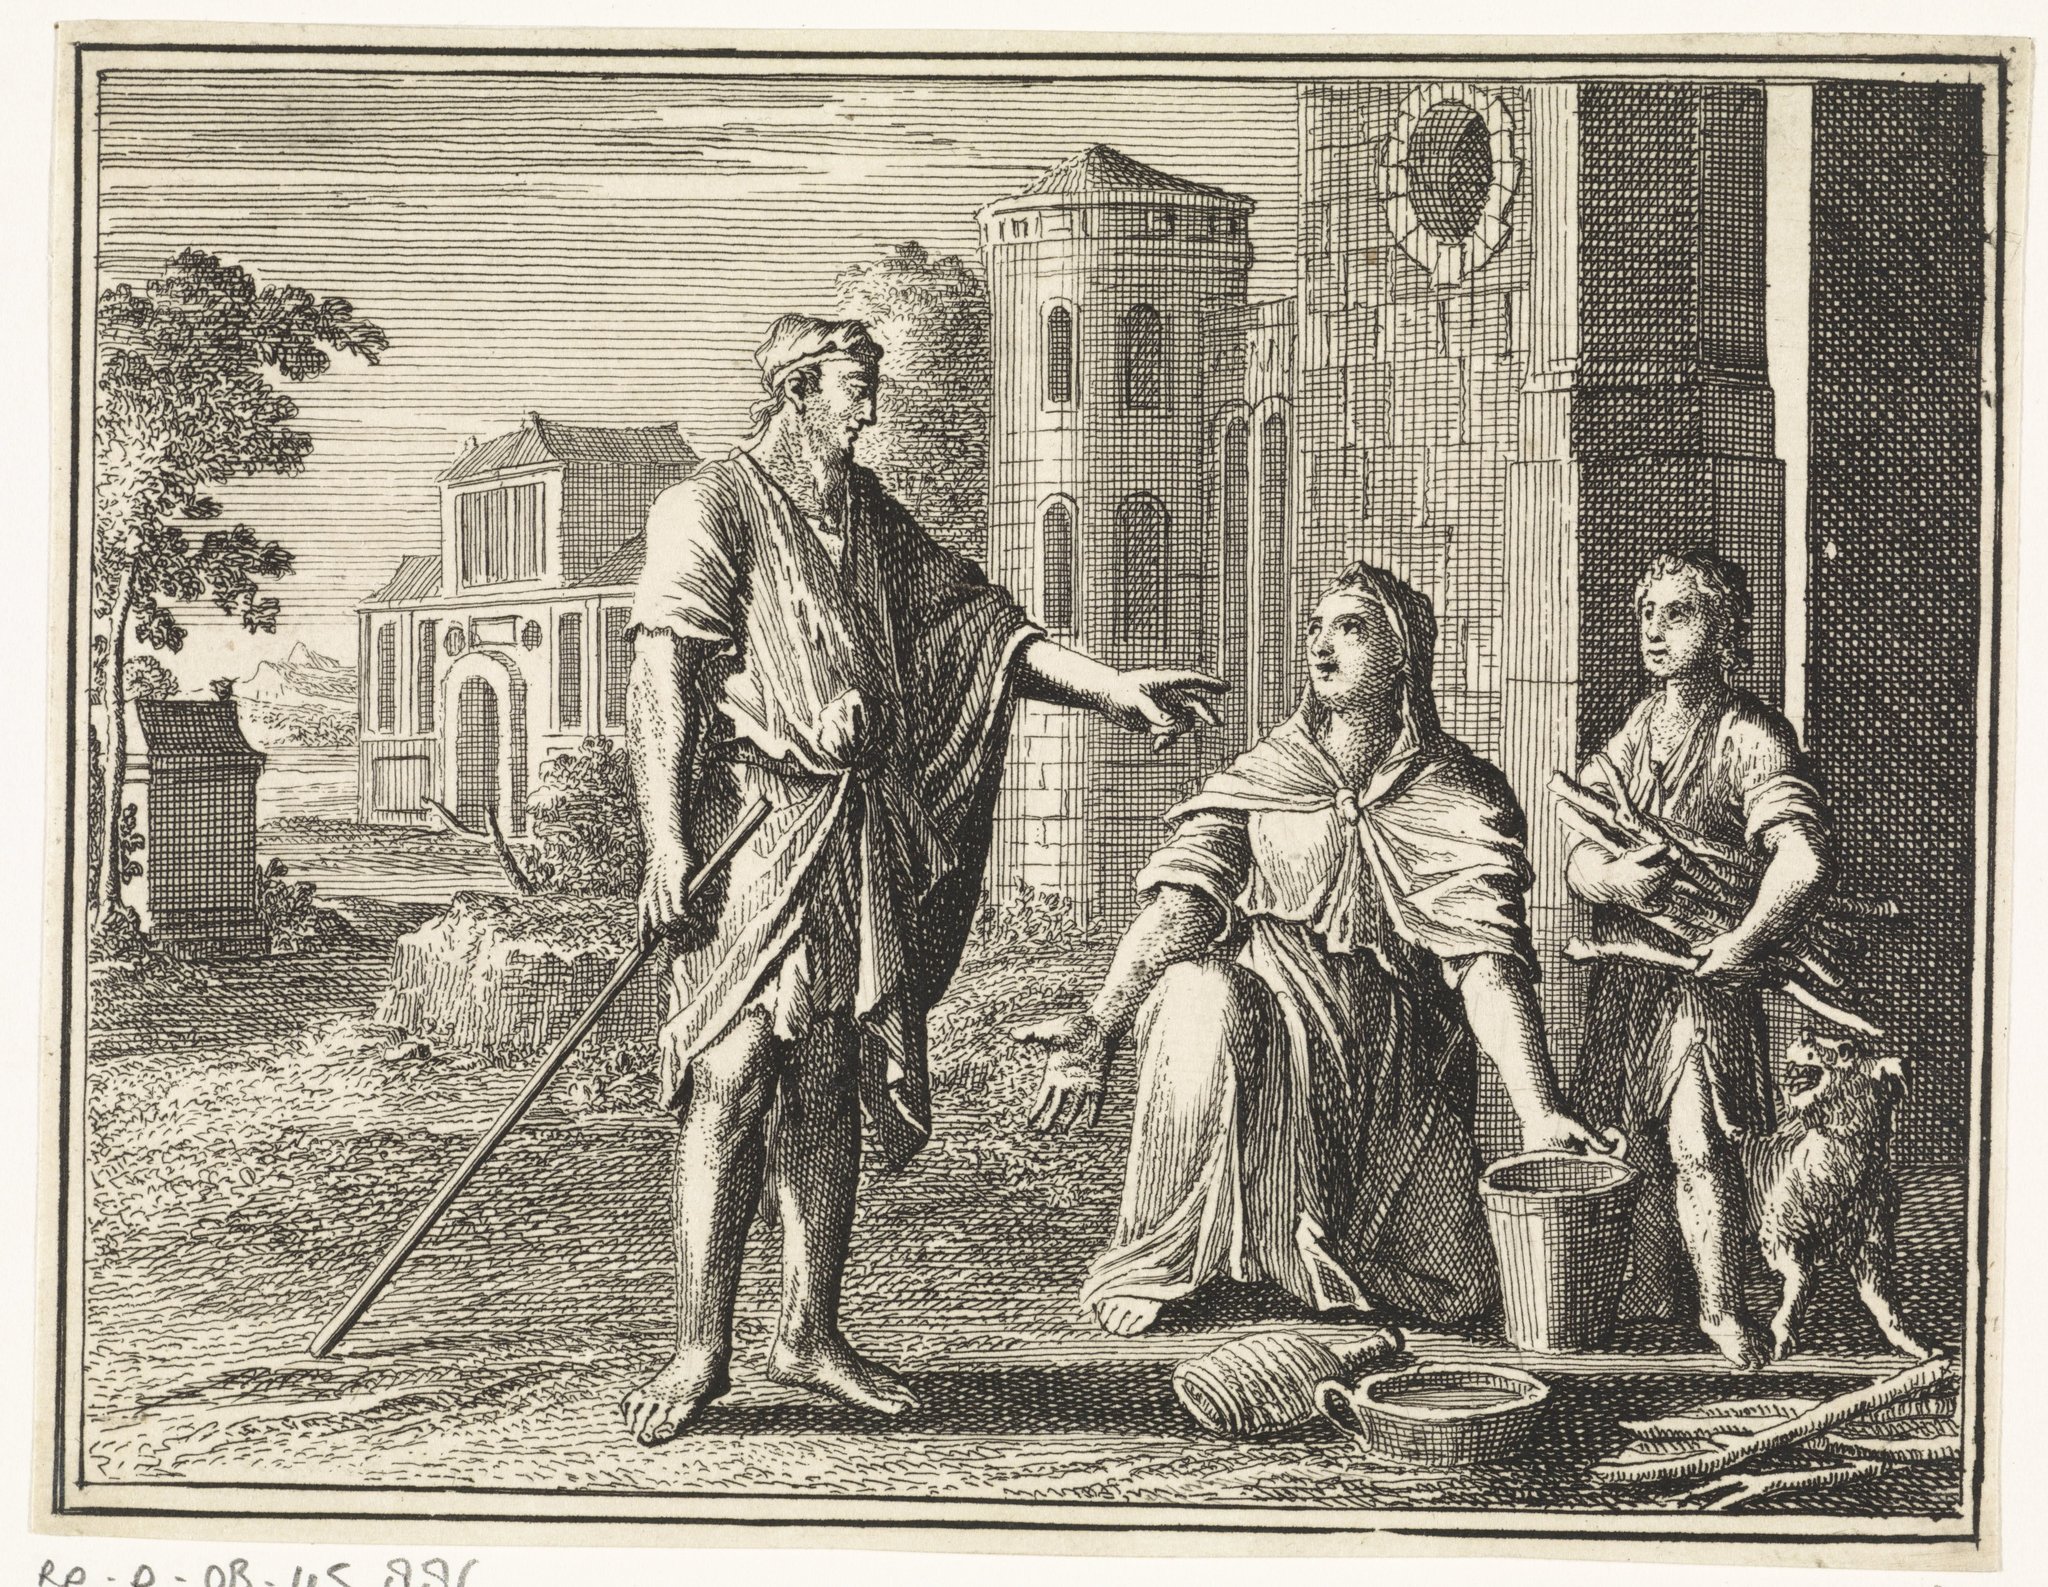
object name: print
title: Elia en de weduwe van Sarefat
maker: caspar luyken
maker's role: draughtsman, print maker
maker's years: 1672-1708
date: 1712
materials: paper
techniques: etching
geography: amsterdam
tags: elijah and the widow of zarephath (1 kings 17:7-24)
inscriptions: number: ‘132’, collector's mark: Lugt 2228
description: Illustratie uit: Luyken, Jan. De schriftuurlyke geschiedenissen en gelykenissen van het Oude en Nieuwe Verbond, 2 delen. Amsterdam: Wed. Pieter Arentsz II en Cornelis van der Sys, 1712, dl. I.